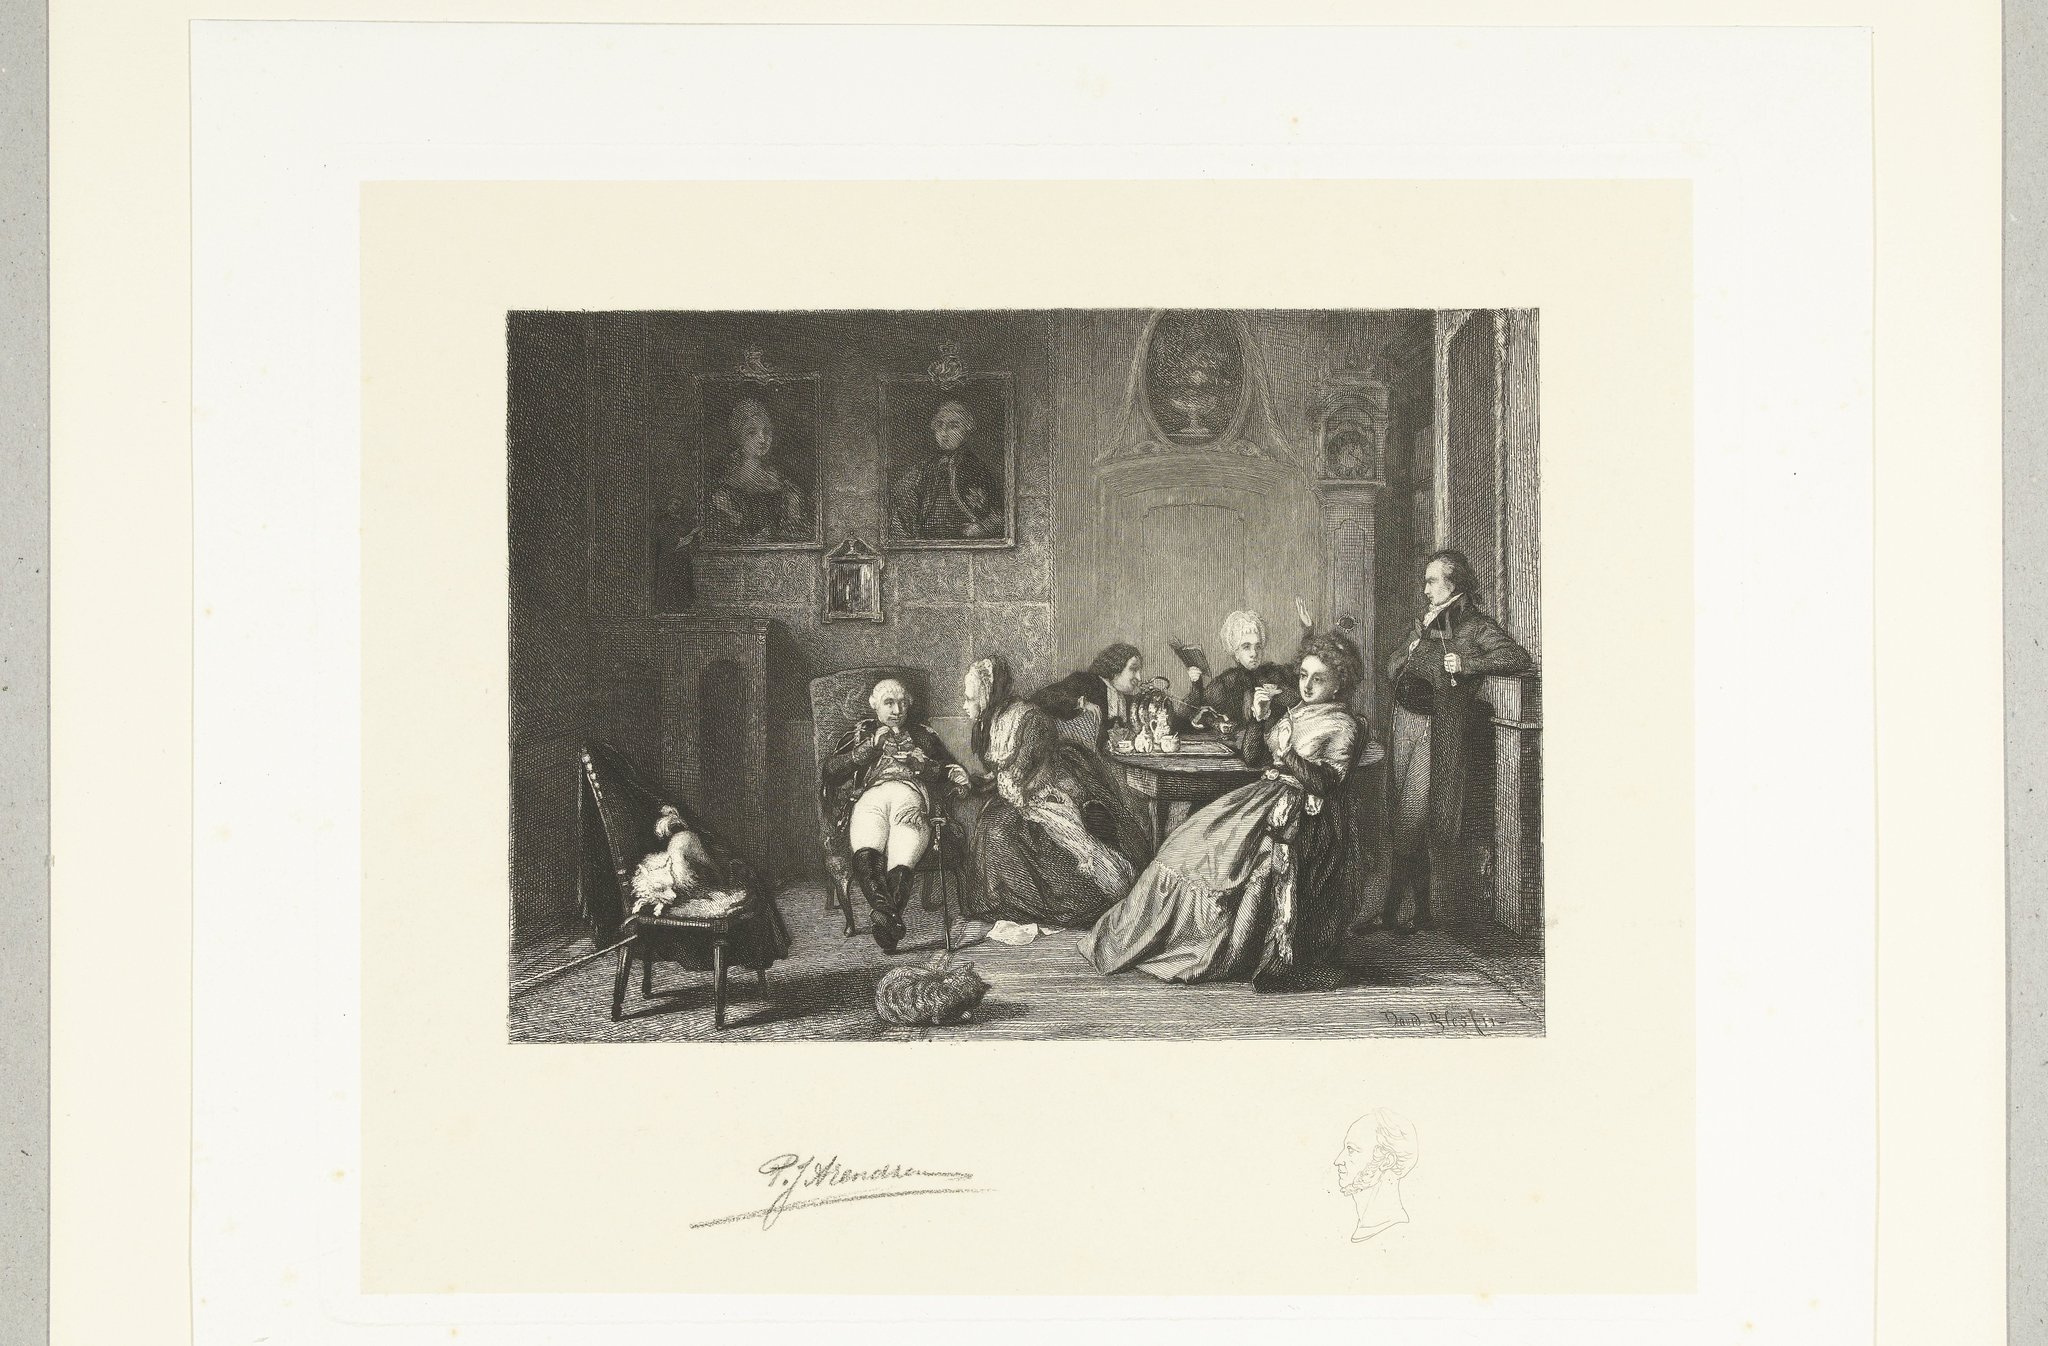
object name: print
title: Orangisten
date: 1856-1909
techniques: printmaking, etching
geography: netherlands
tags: william ii of the netherlands, living-room, parlour, sitting-room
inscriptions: collector's mark: Lugt 2228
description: Een gezelschap dames en heren drinkt thee in een salon. Één man draagt een uniform. In marge een portretbuste van Willem II.